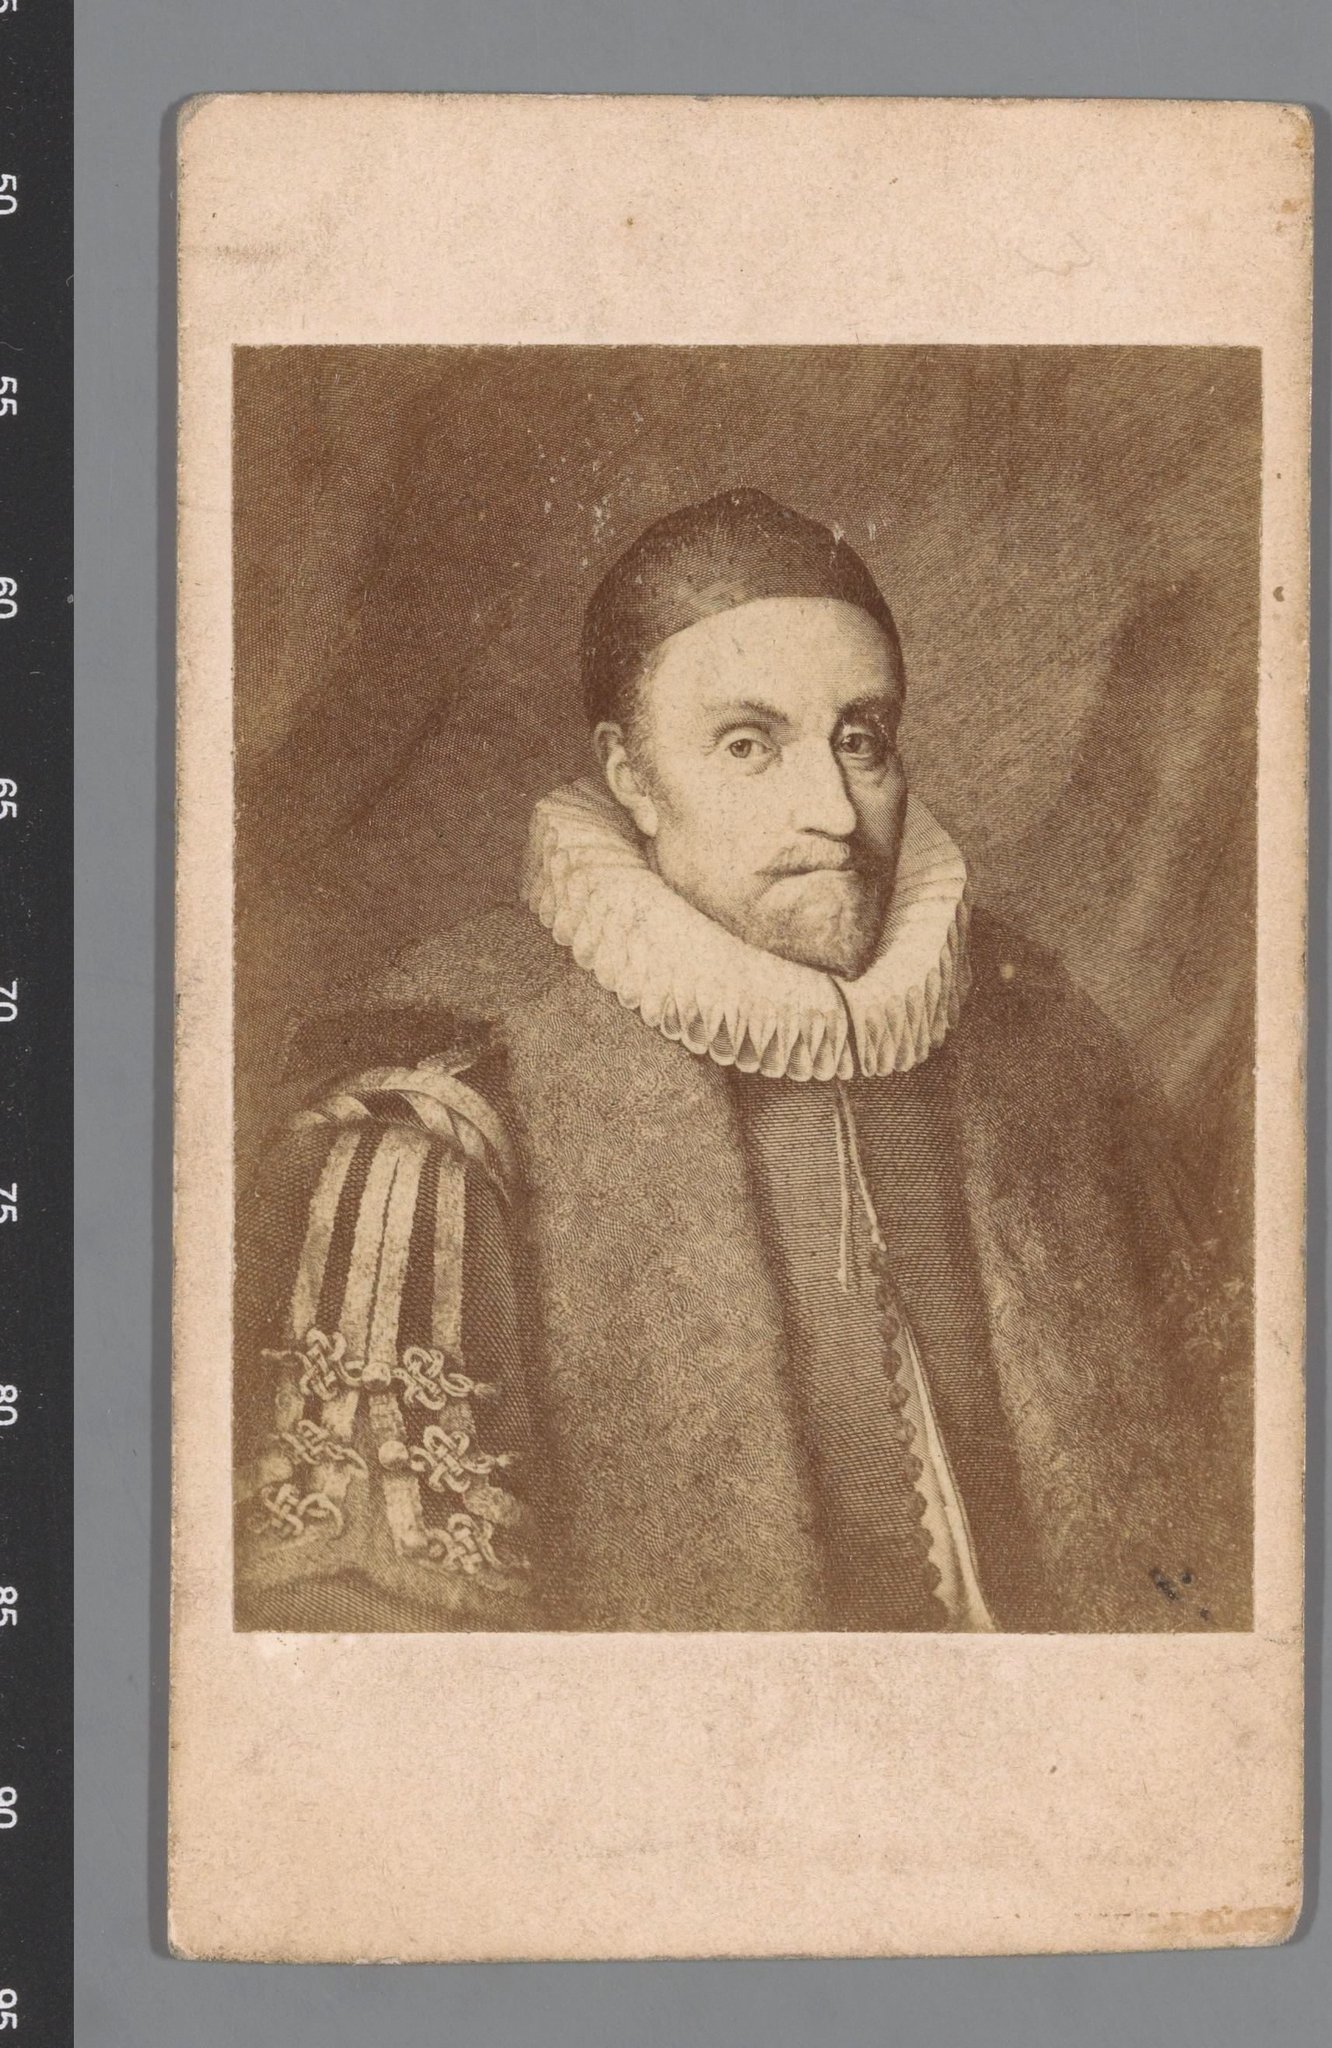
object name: reproduction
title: Fotoreproductie van een gravure van een portret van Willem I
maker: Anonymous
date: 1850-1900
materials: cardboard, photographic support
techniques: albumen print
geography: netherlands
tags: delft, william i (prince of orange), historical persons, netherlands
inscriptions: inscription: ‘1. Portret van (...) van Noord-Nederland.’